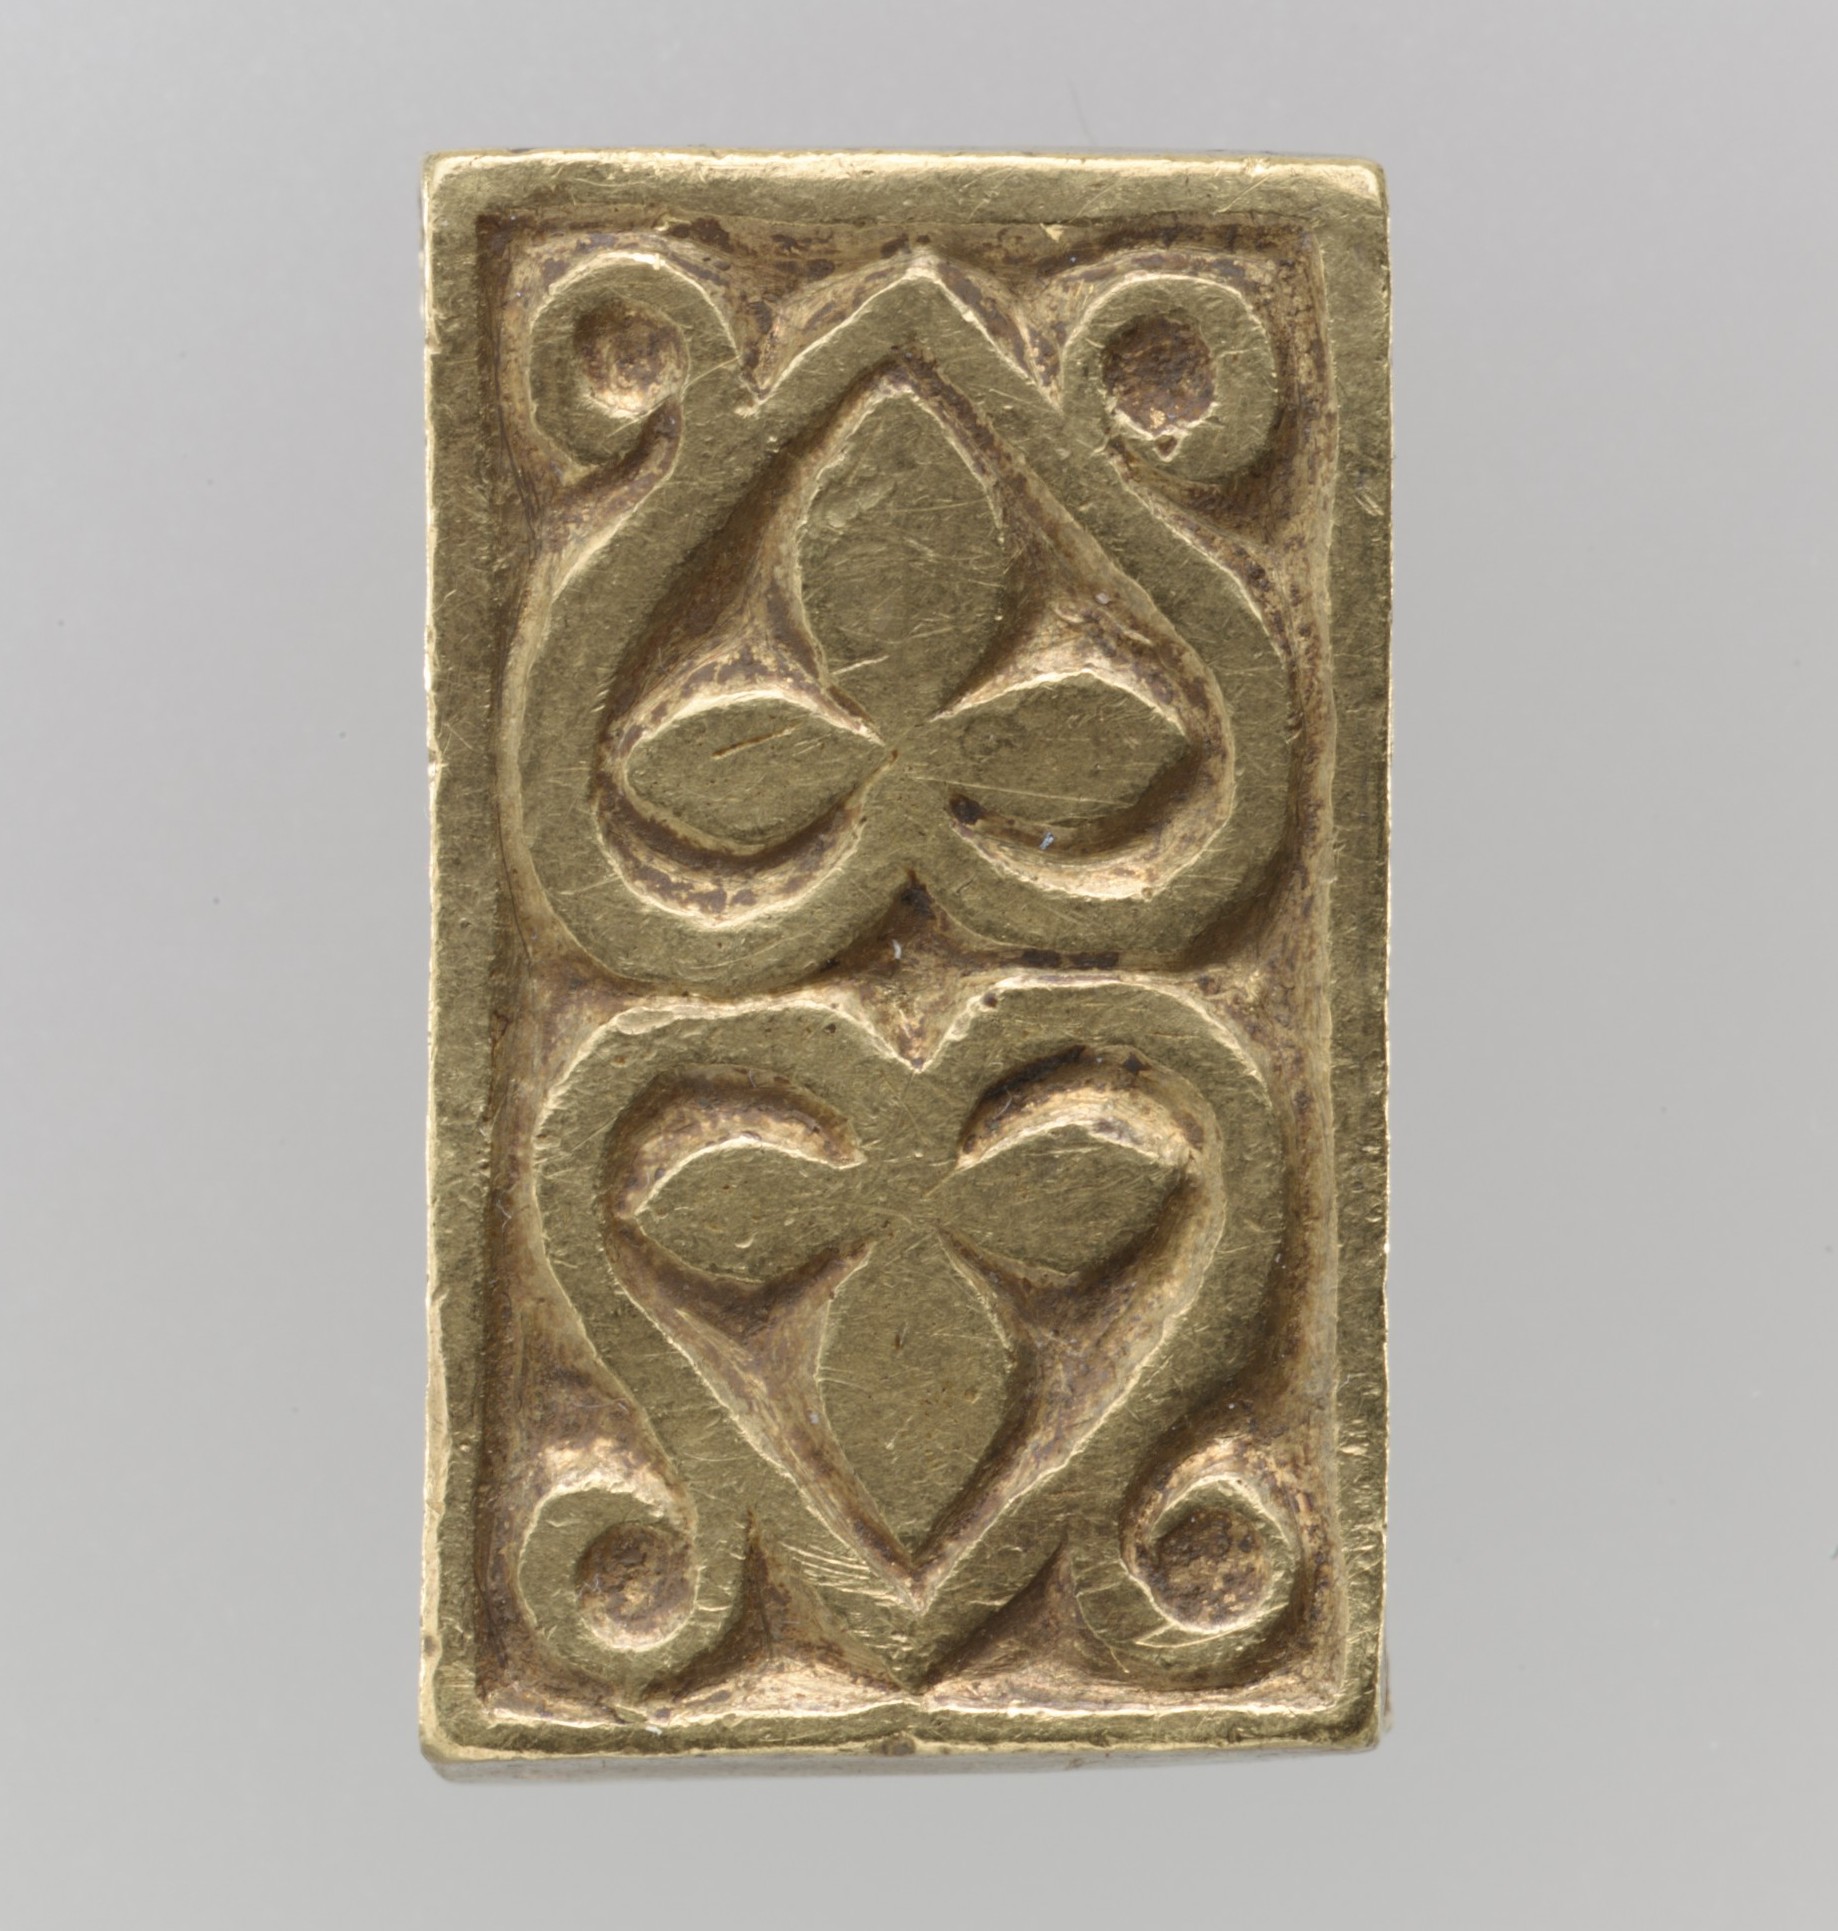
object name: belt slide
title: Gold Slide for a Belt or Strap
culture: avar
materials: gold